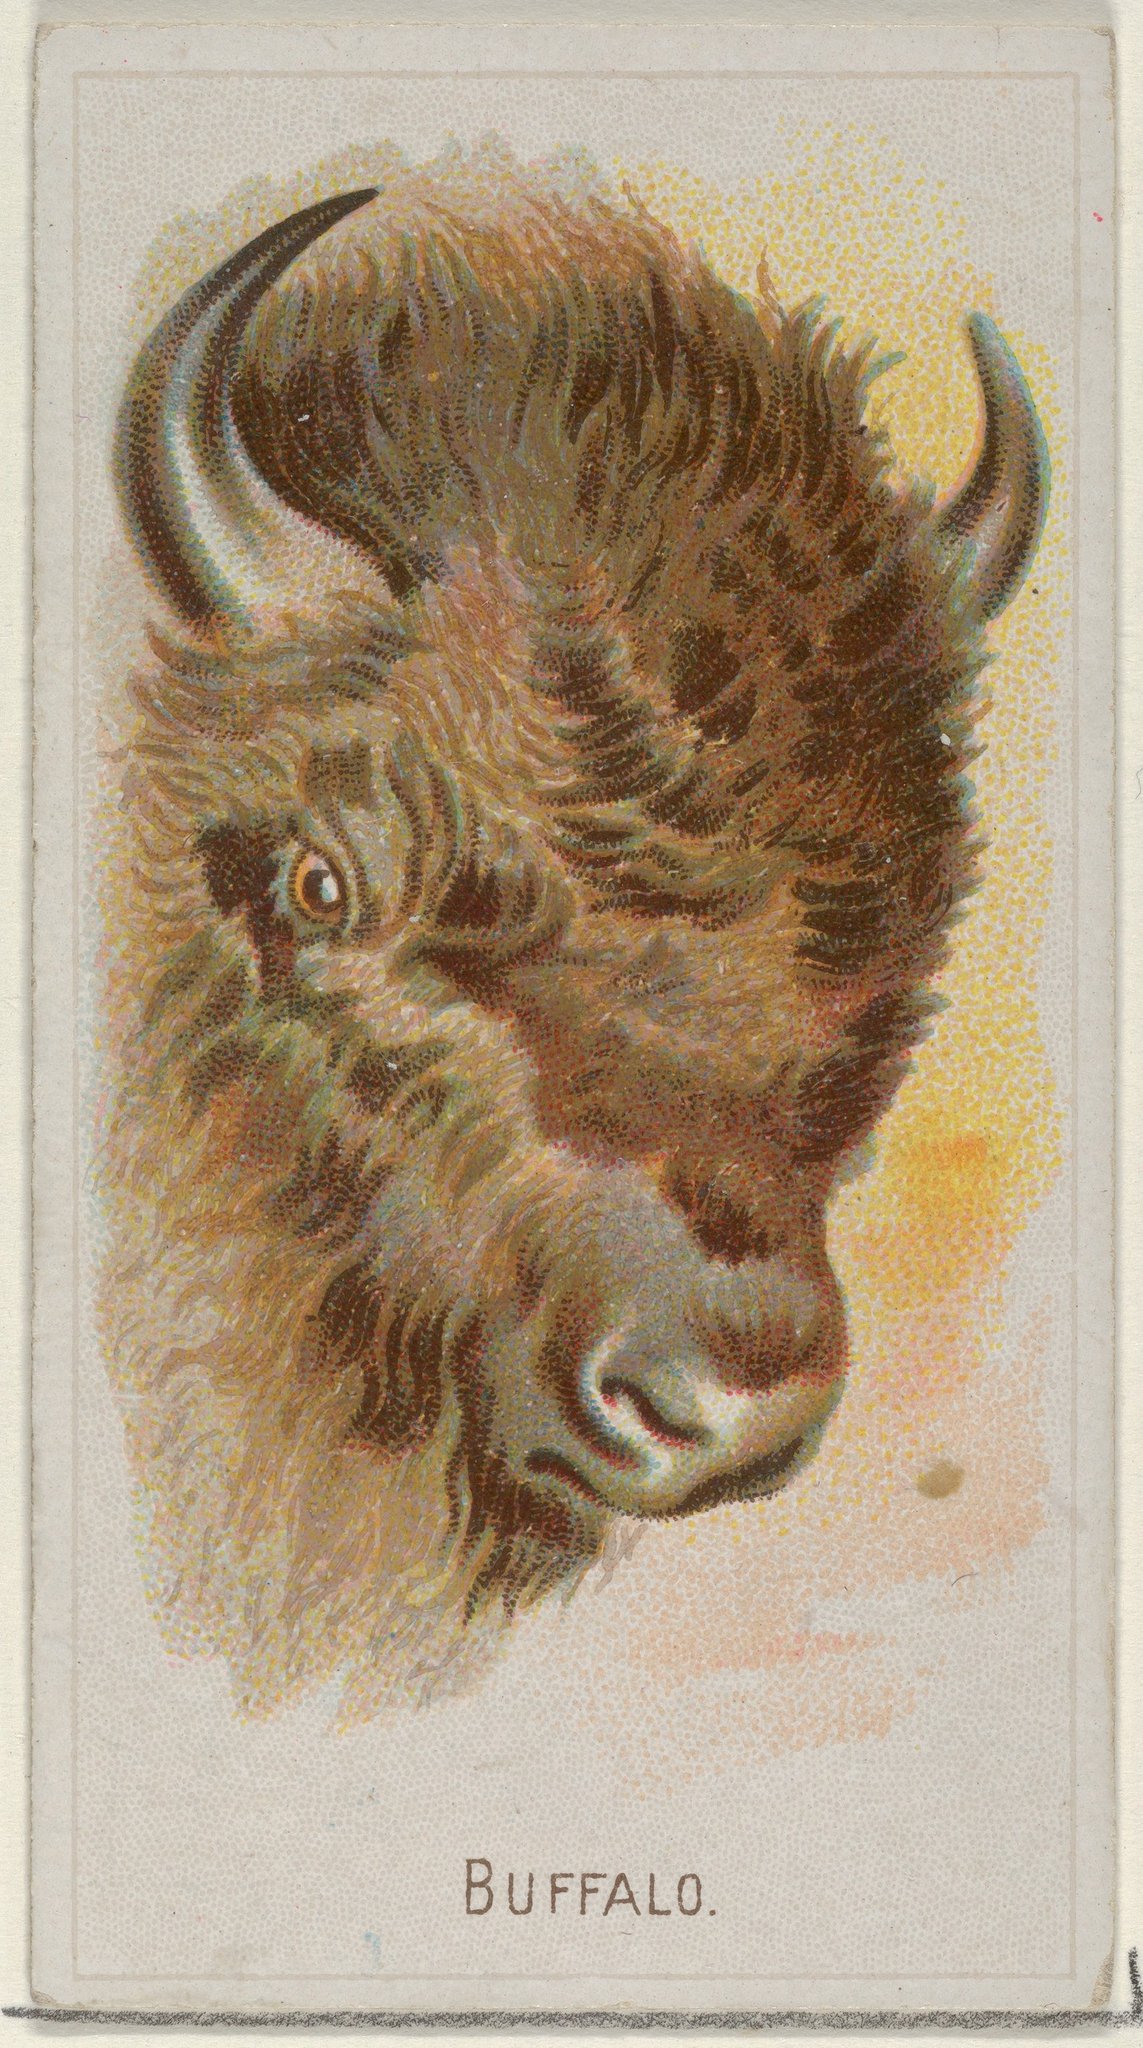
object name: print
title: Buffalo, from the Wild Animals of the World series (N25) for Allen & Ginter Cigarettes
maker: allen & ginter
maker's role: publisher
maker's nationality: american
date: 1888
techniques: color lithograph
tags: buffalos